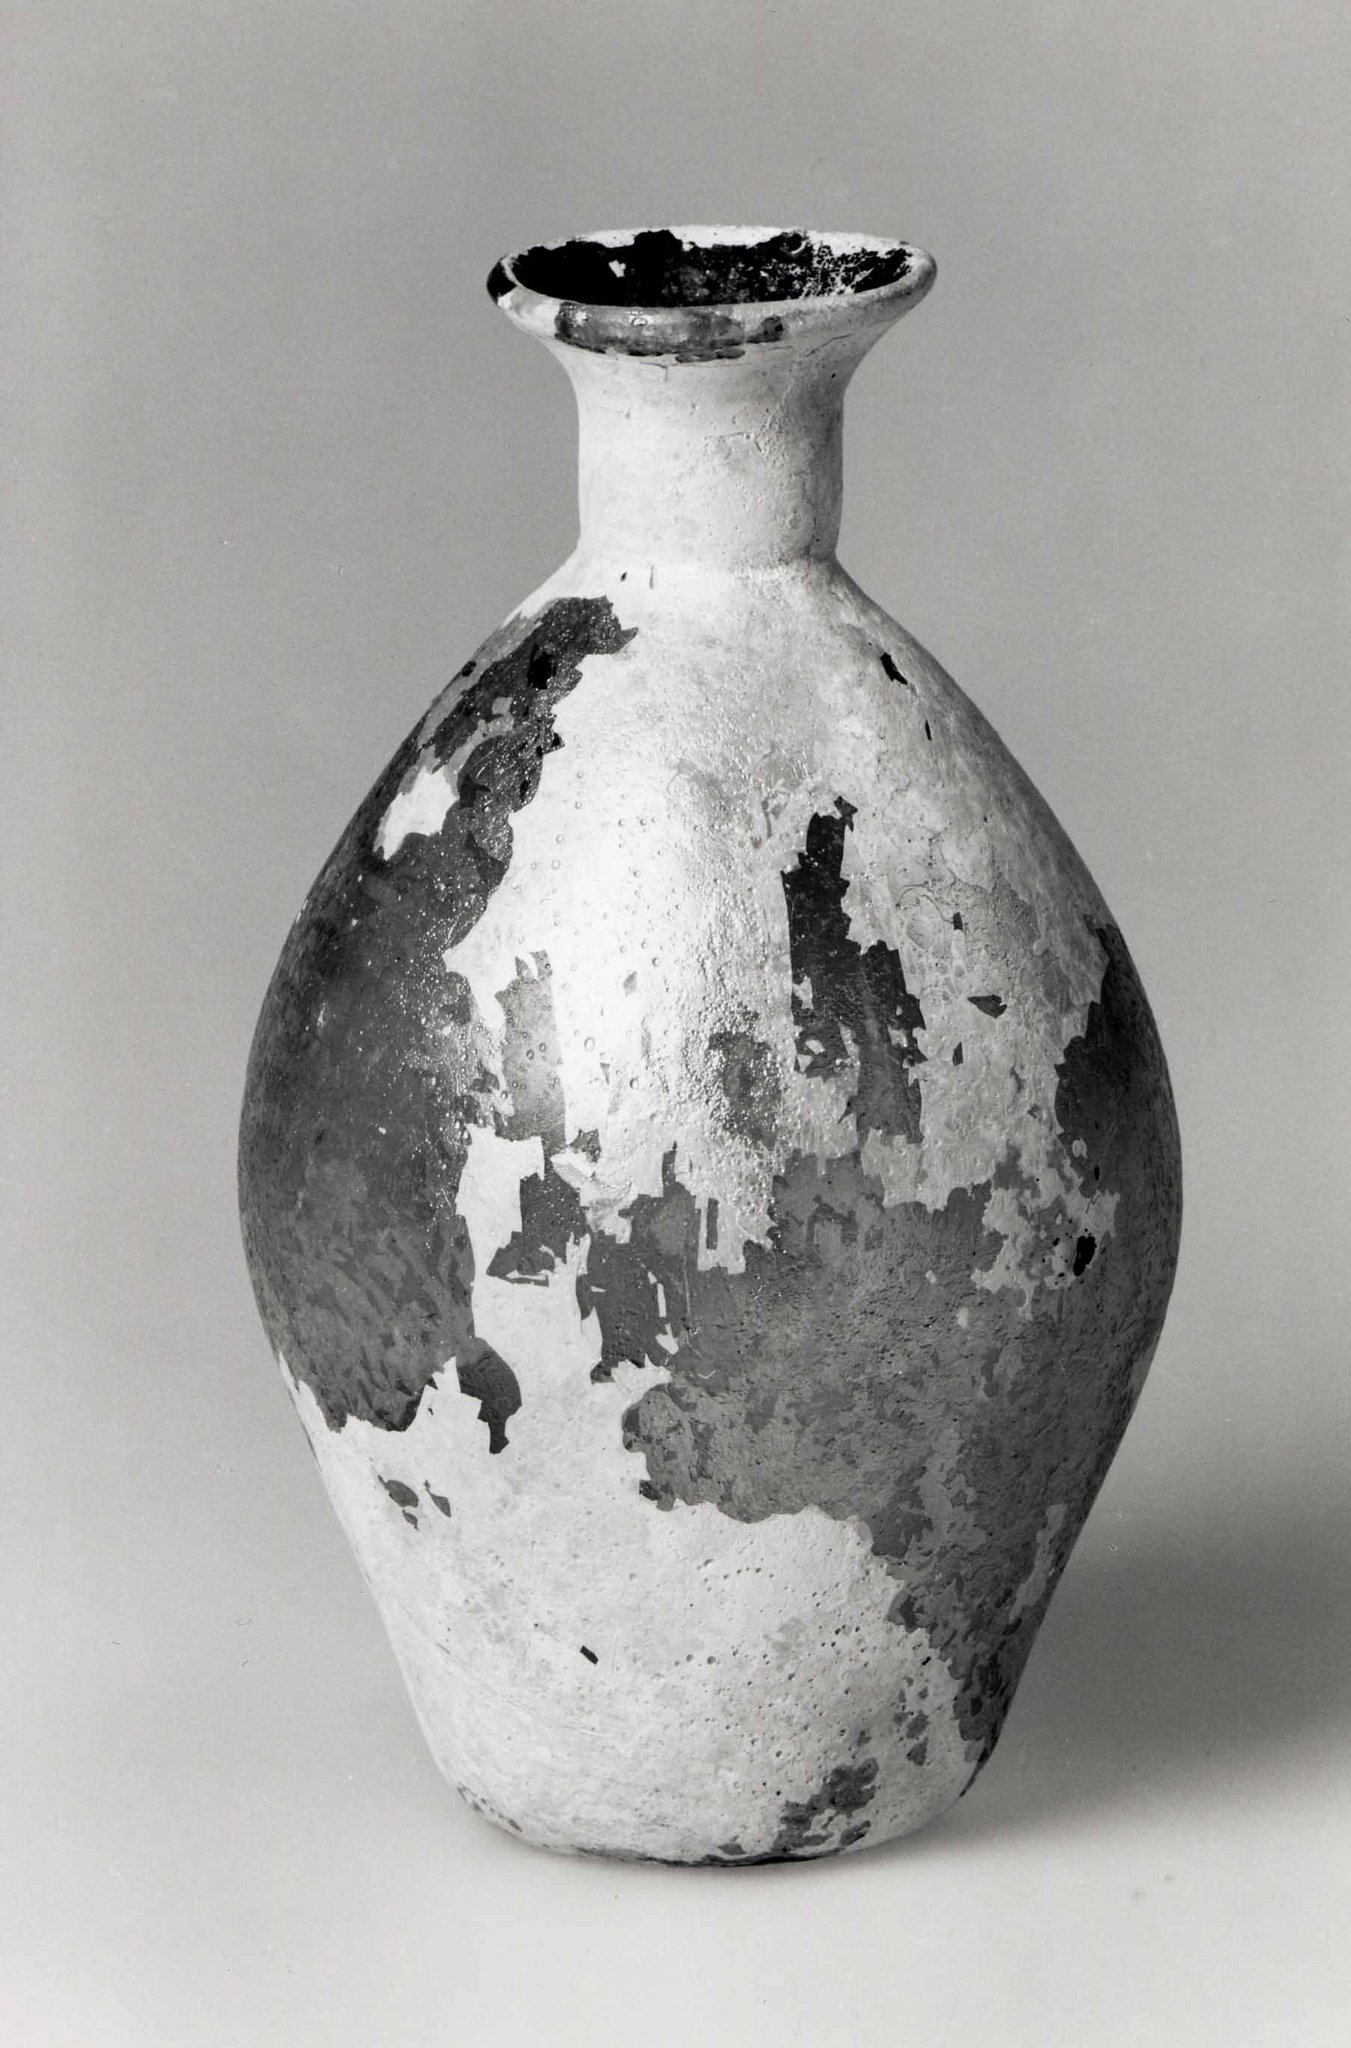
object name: jar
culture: roman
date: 267-500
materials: glass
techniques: glassblowing